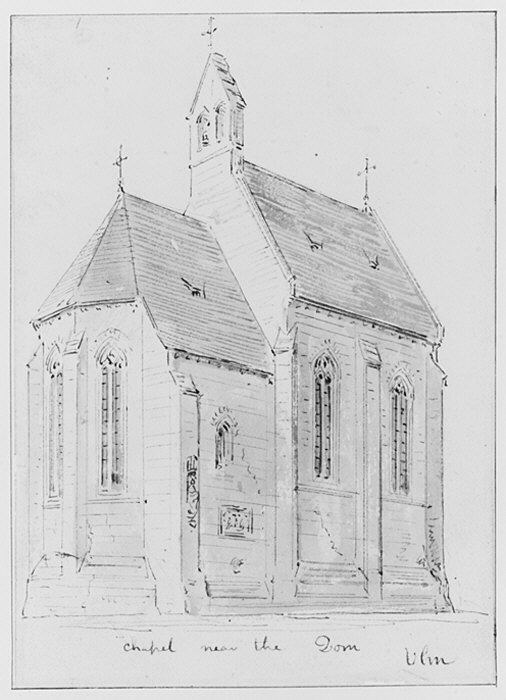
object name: album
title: Sketches, Volume four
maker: augustus welby northmore pugin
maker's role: designer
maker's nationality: british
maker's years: 1812-1852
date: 1838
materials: graphite, ink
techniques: brush, pen, wash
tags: churches